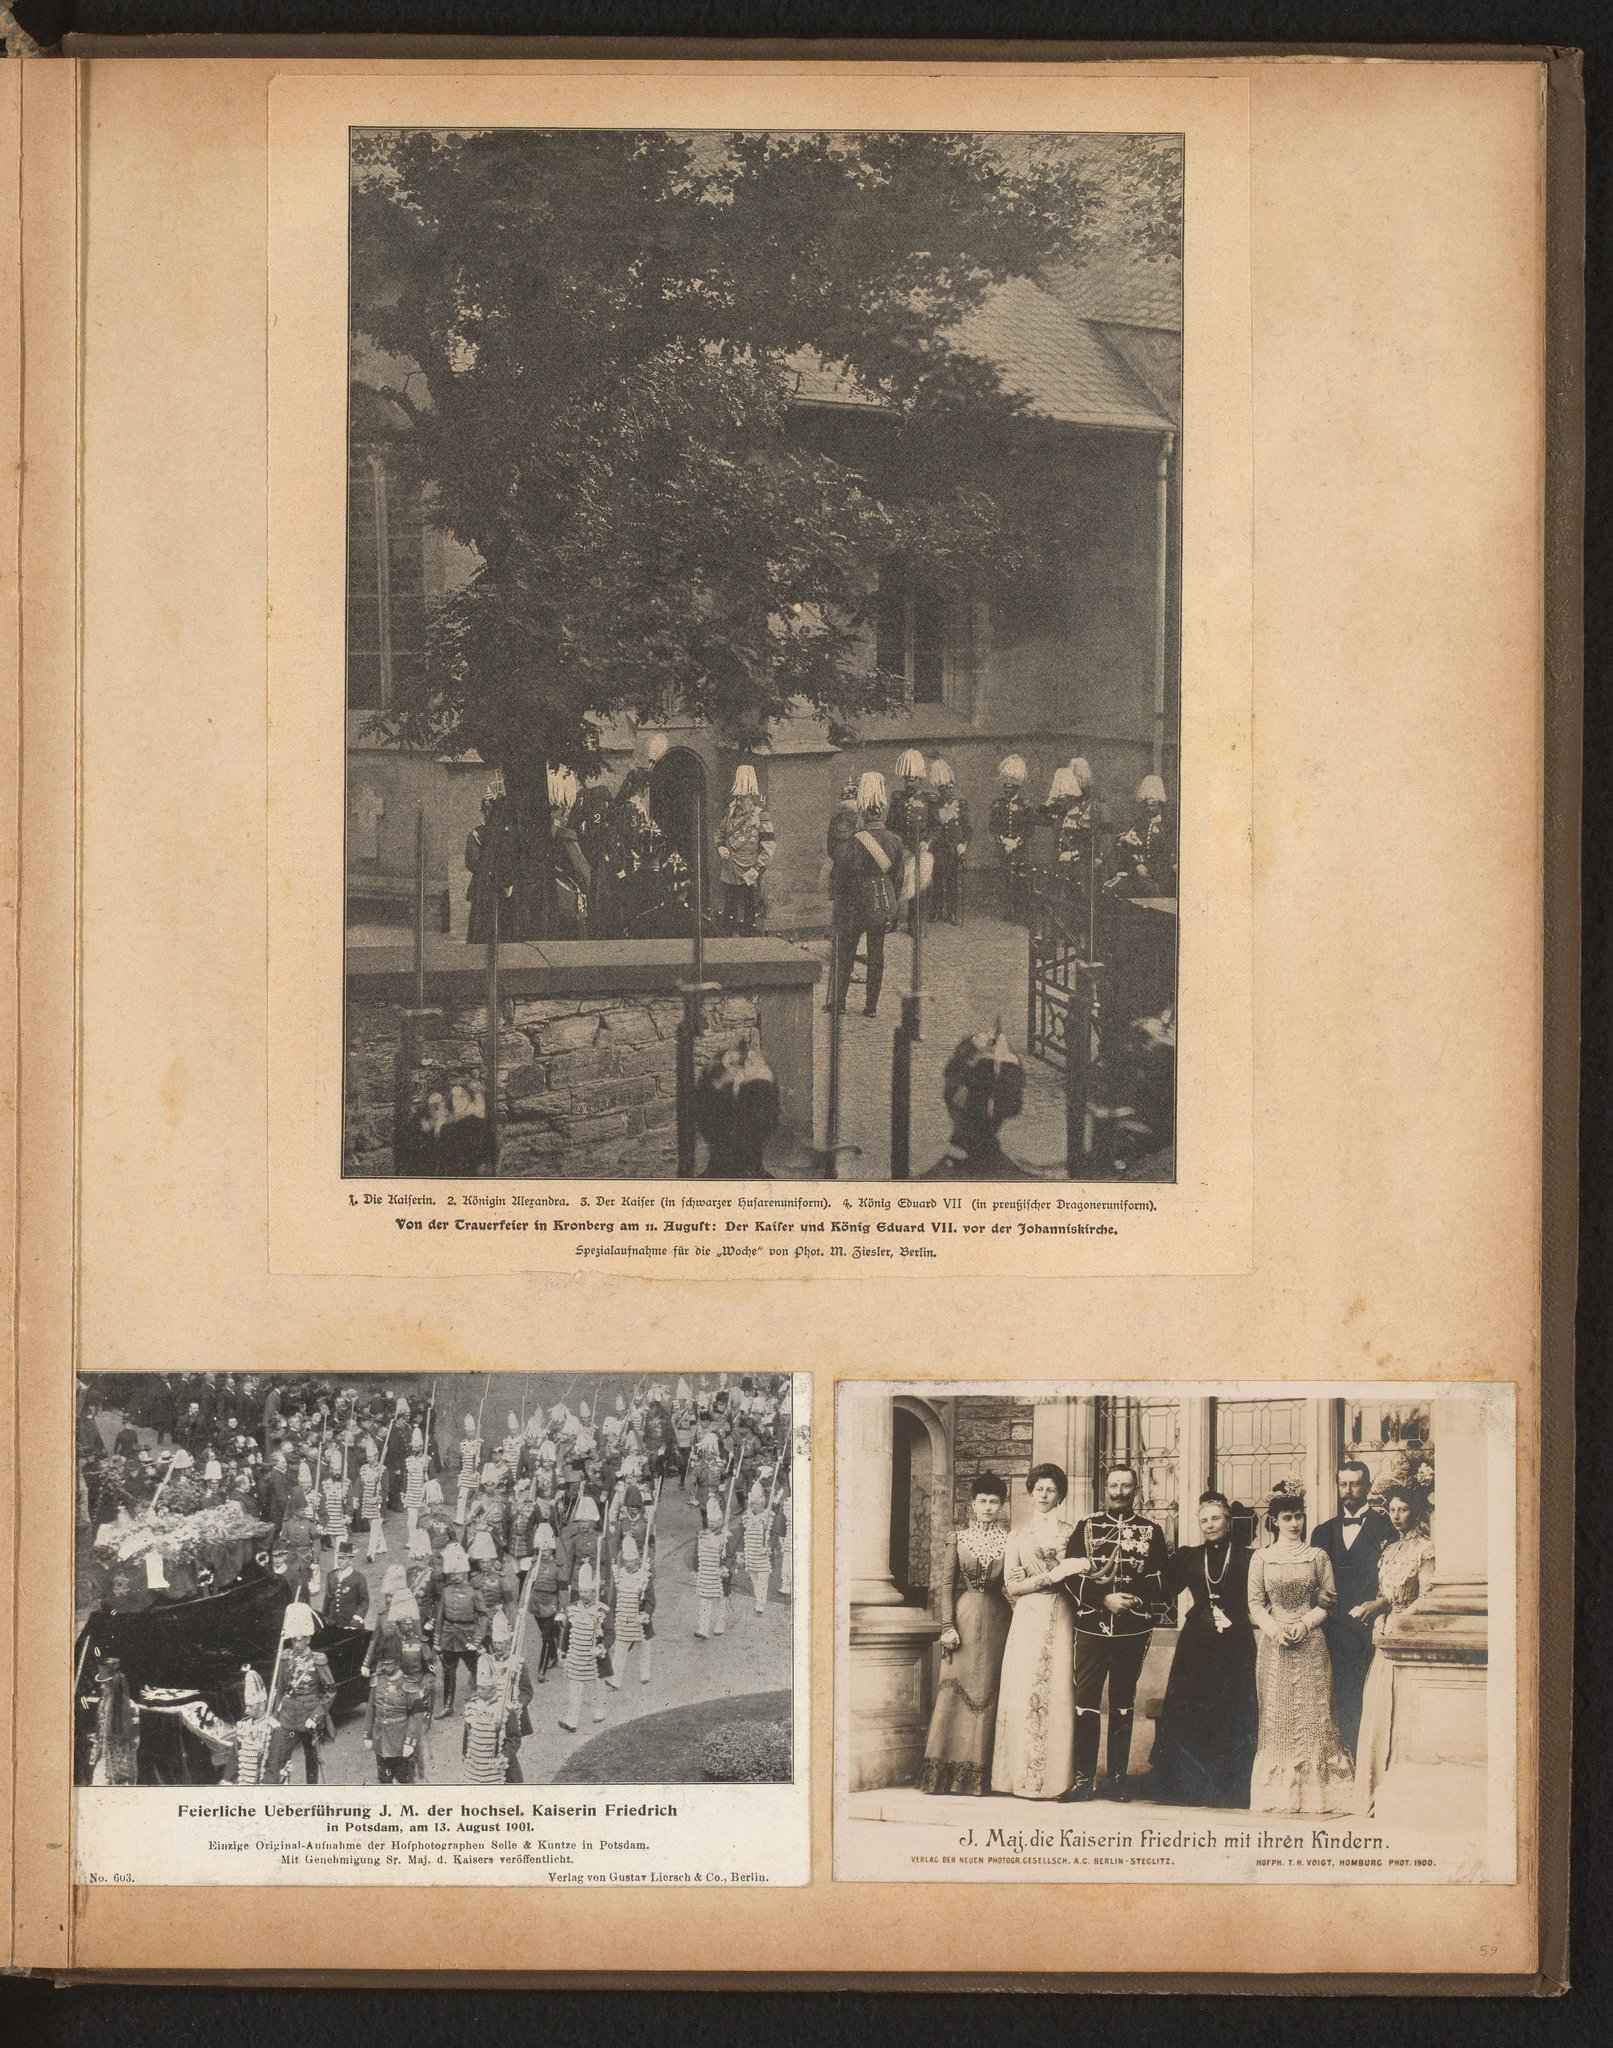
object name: photograph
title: Drie officiële gelegenheden met de Duitse keizerlijke familie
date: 1900-1901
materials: paper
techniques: gelatin silver print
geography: berlin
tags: wilhelm ii (keizer van duitsland), victoria van saksen-coburg en gotha (duits keizerin), queen, empress, etc. (wife of a ruler), emperor, public funeral, family of the sovereign, berlin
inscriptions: inscription: ‘J. Maj. die (...) Homburg Phot. 1900.’, inscription: ‘Feierliche Ueberführung J. M. (...) Liersch & Co., Berlin.’, inscription: ‘1. Die Kaiserin (...) M. Ziesler, Berlin.’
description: Deze foto en fotomechanische afdrukken maken deel uit van een album.